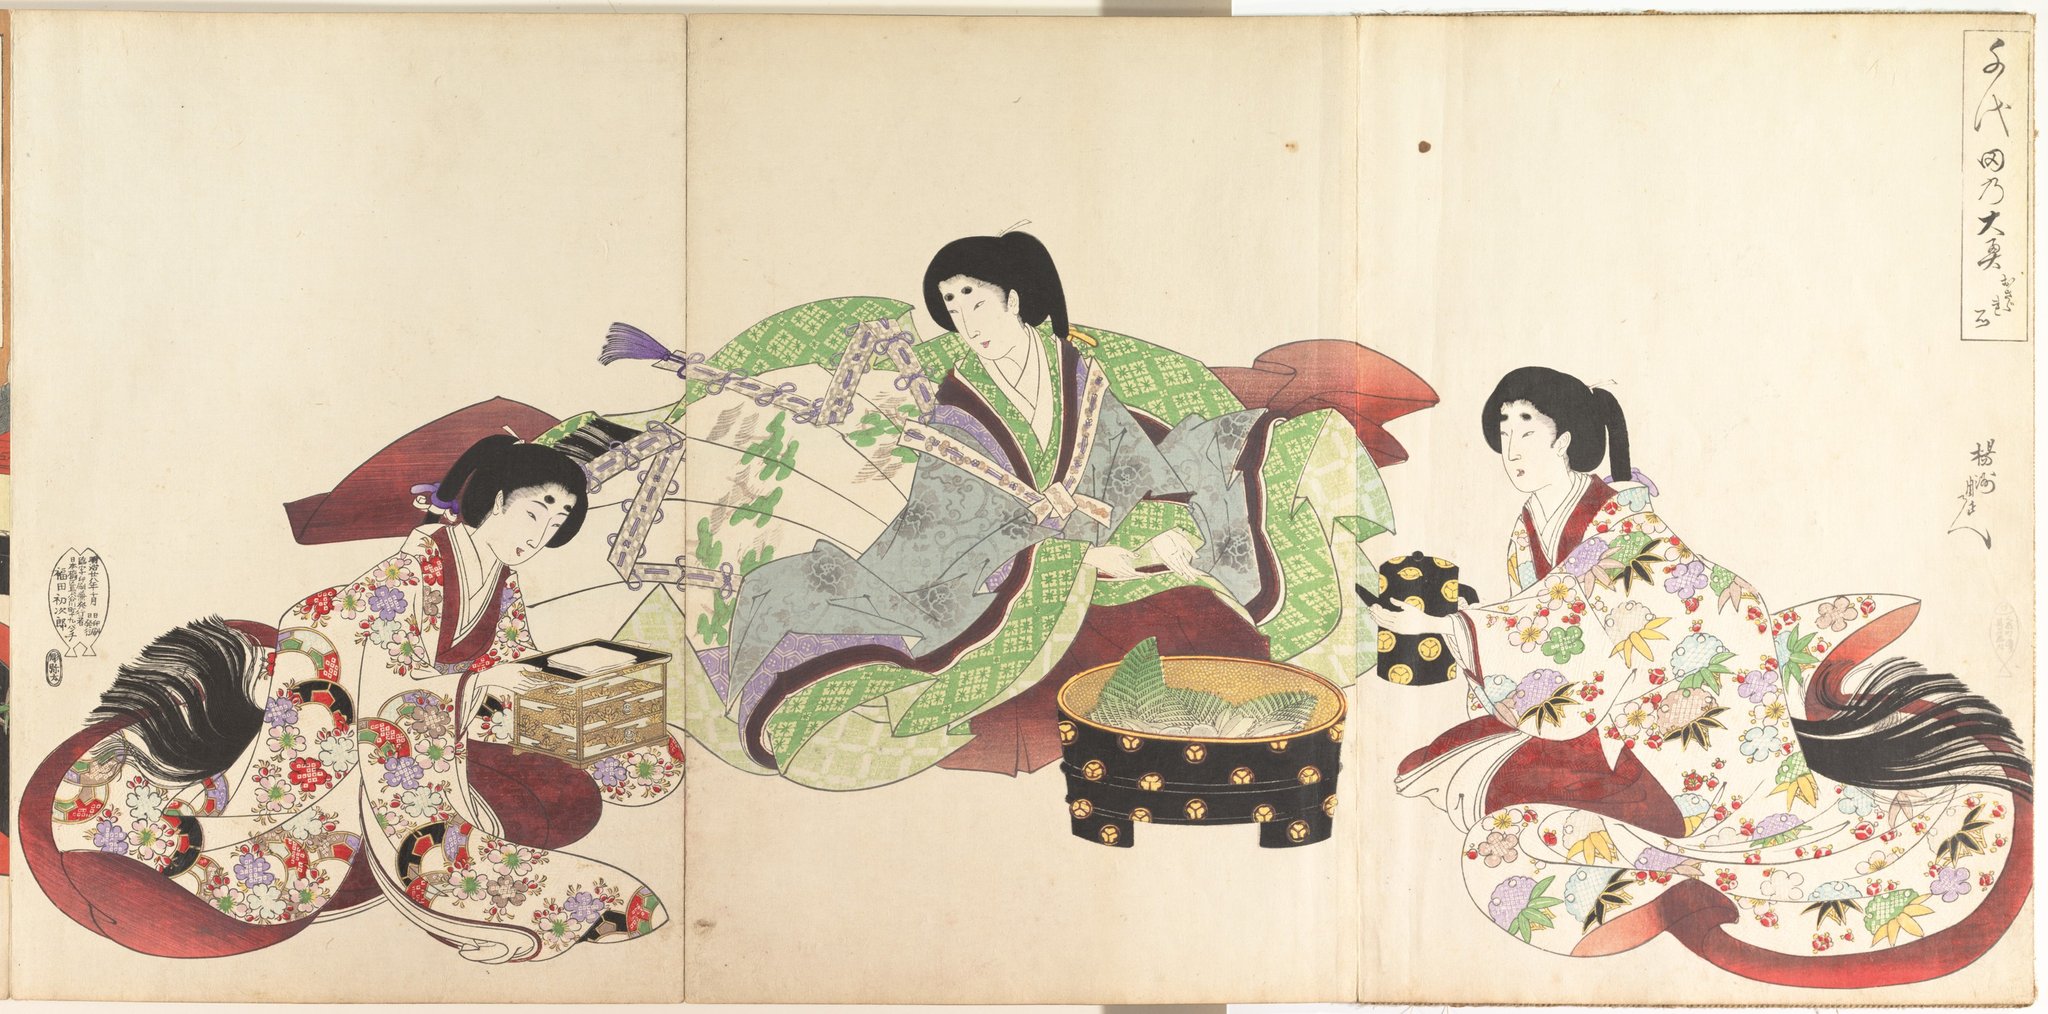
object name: print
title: Chiyoda Castle (Album of Women)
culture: japanese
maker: yōshū (hashimoto) chikanobu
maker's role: artist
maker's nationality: japanese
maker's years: 1838-1912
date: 1895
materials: ink, paper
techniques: woodblock print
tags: women